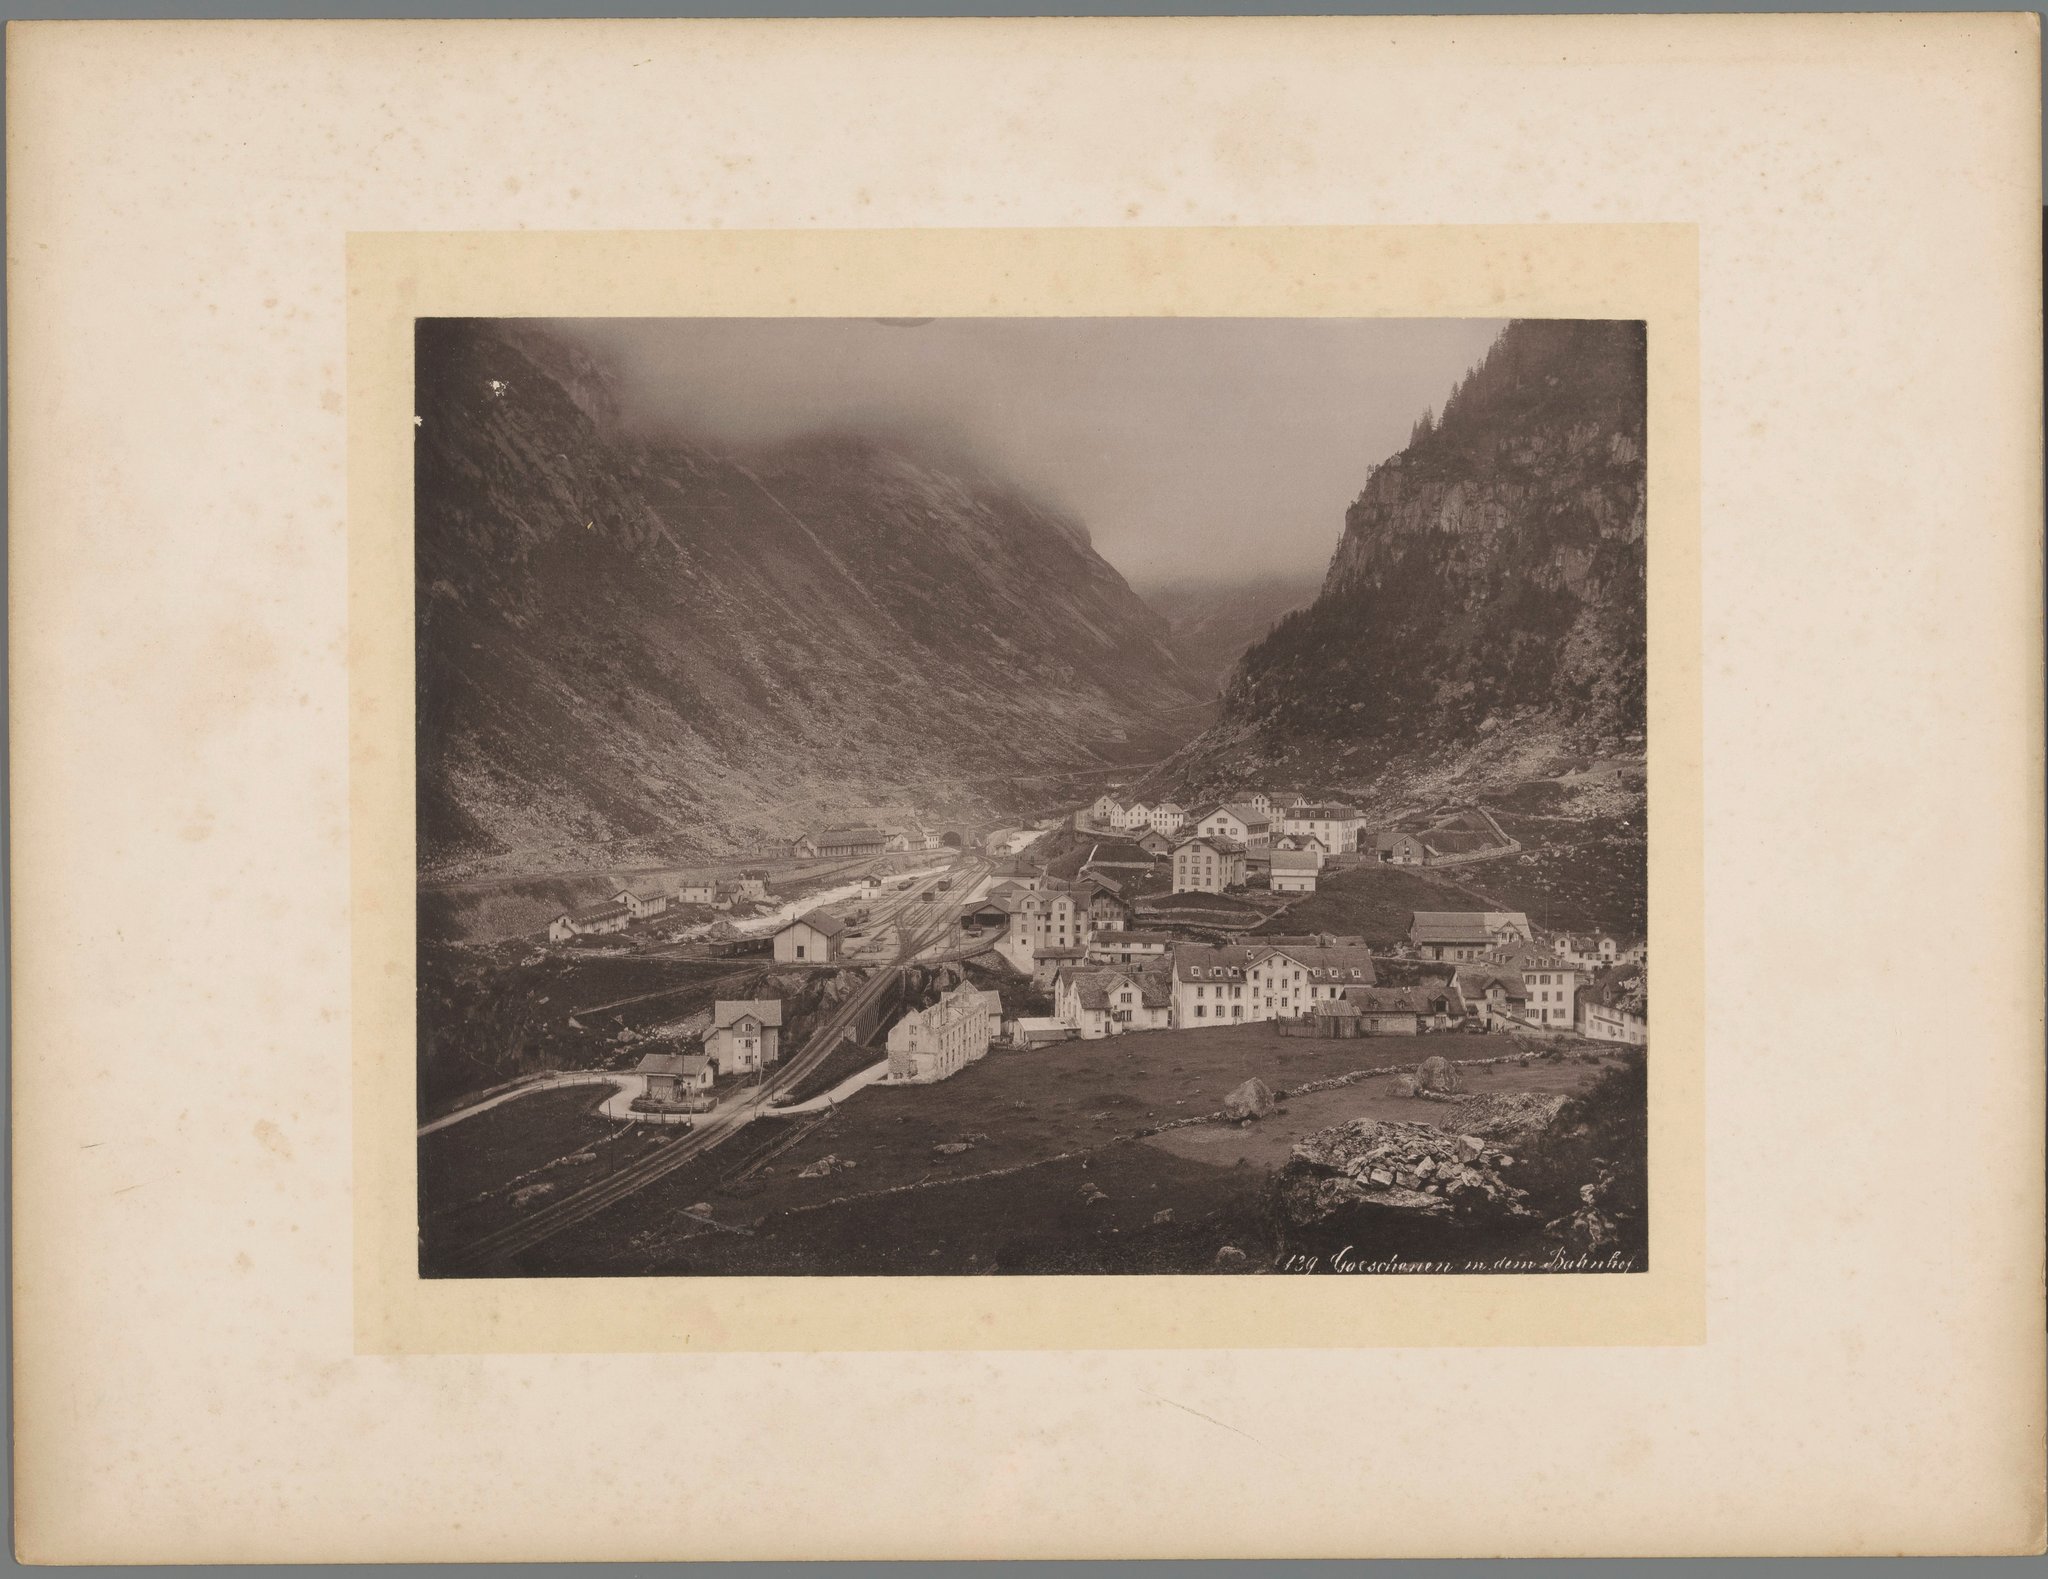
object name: photomechanical print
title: Goeschenen in dem Bahnhof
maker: Anonymous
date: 1870-1930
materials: cardboard, paper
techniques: photograph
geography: göschenen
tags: city-view in general; 'veduta'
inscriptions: number: ‘139.’